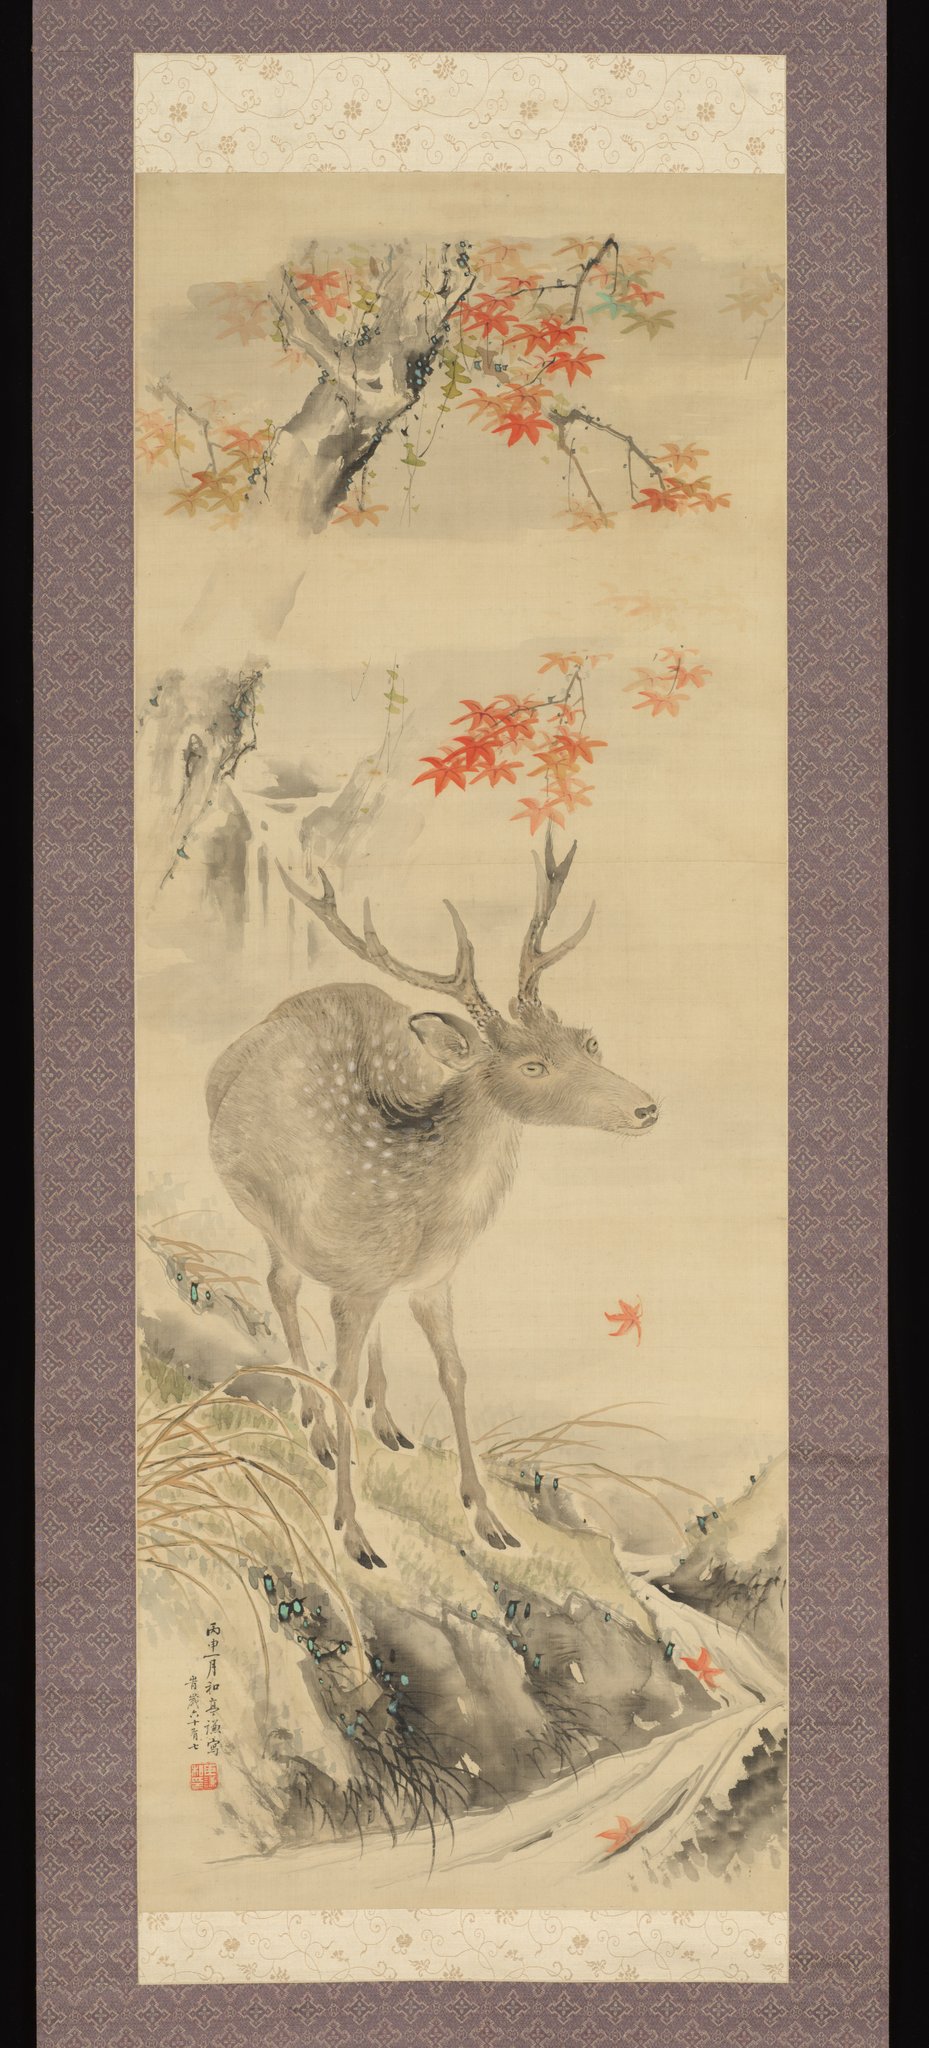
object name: hanging scroll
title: Deer by Mountain Stream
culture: japanese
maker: taki katei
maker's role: artist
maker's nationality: japanese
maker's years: 1830-1901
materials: ink, silk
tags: deer